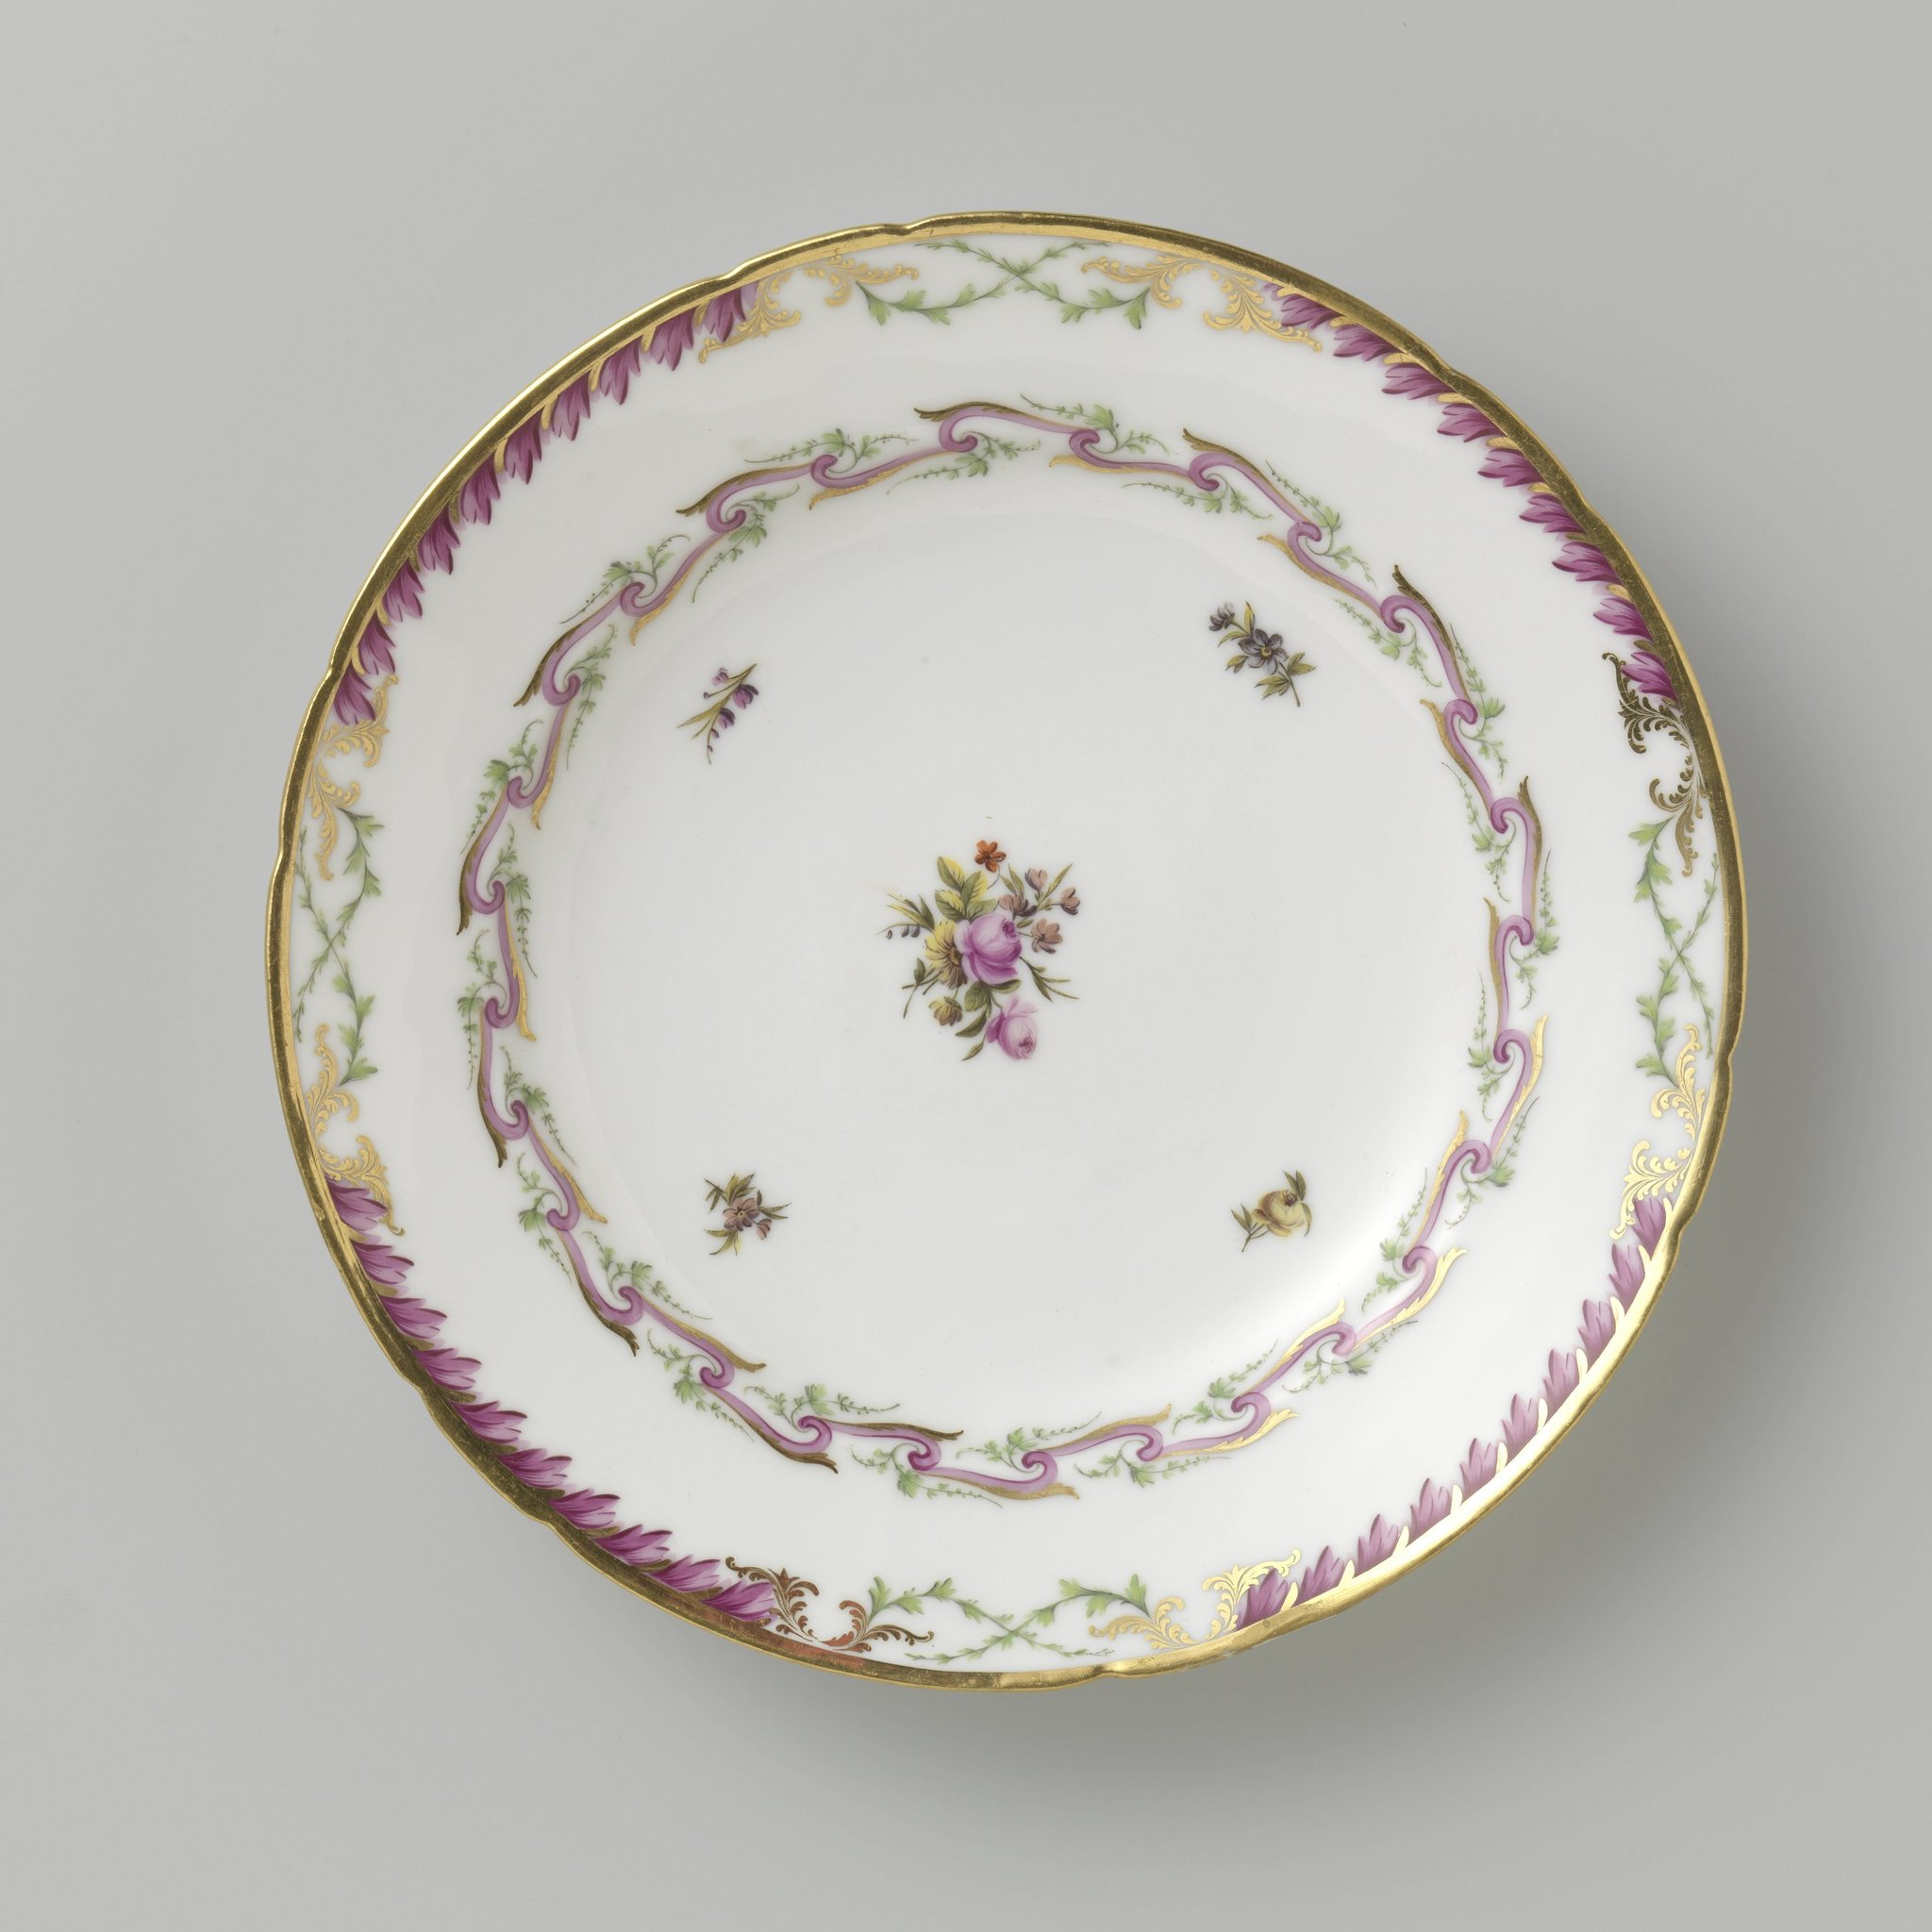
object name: plate dish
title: Bord, plat model, behorend bij een servies met geslingerd lintmotief met bladertakken, bloemboeketten en gestrooide bloemtakken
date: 1780-1820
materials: porcelain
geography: loosdrecht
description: Bord, plat model, behorend bij een servies van porselein met geslingerd lintmotief in paars en goud met groene bladertakken, bloemboeketten en gestrooide bloemtakken. Randen lichtgegolfd met decoratie in goud met paars bladmotief waartussen groen gekruist bladmotief. Gemerkt: M.O.L. of AMSTEL.